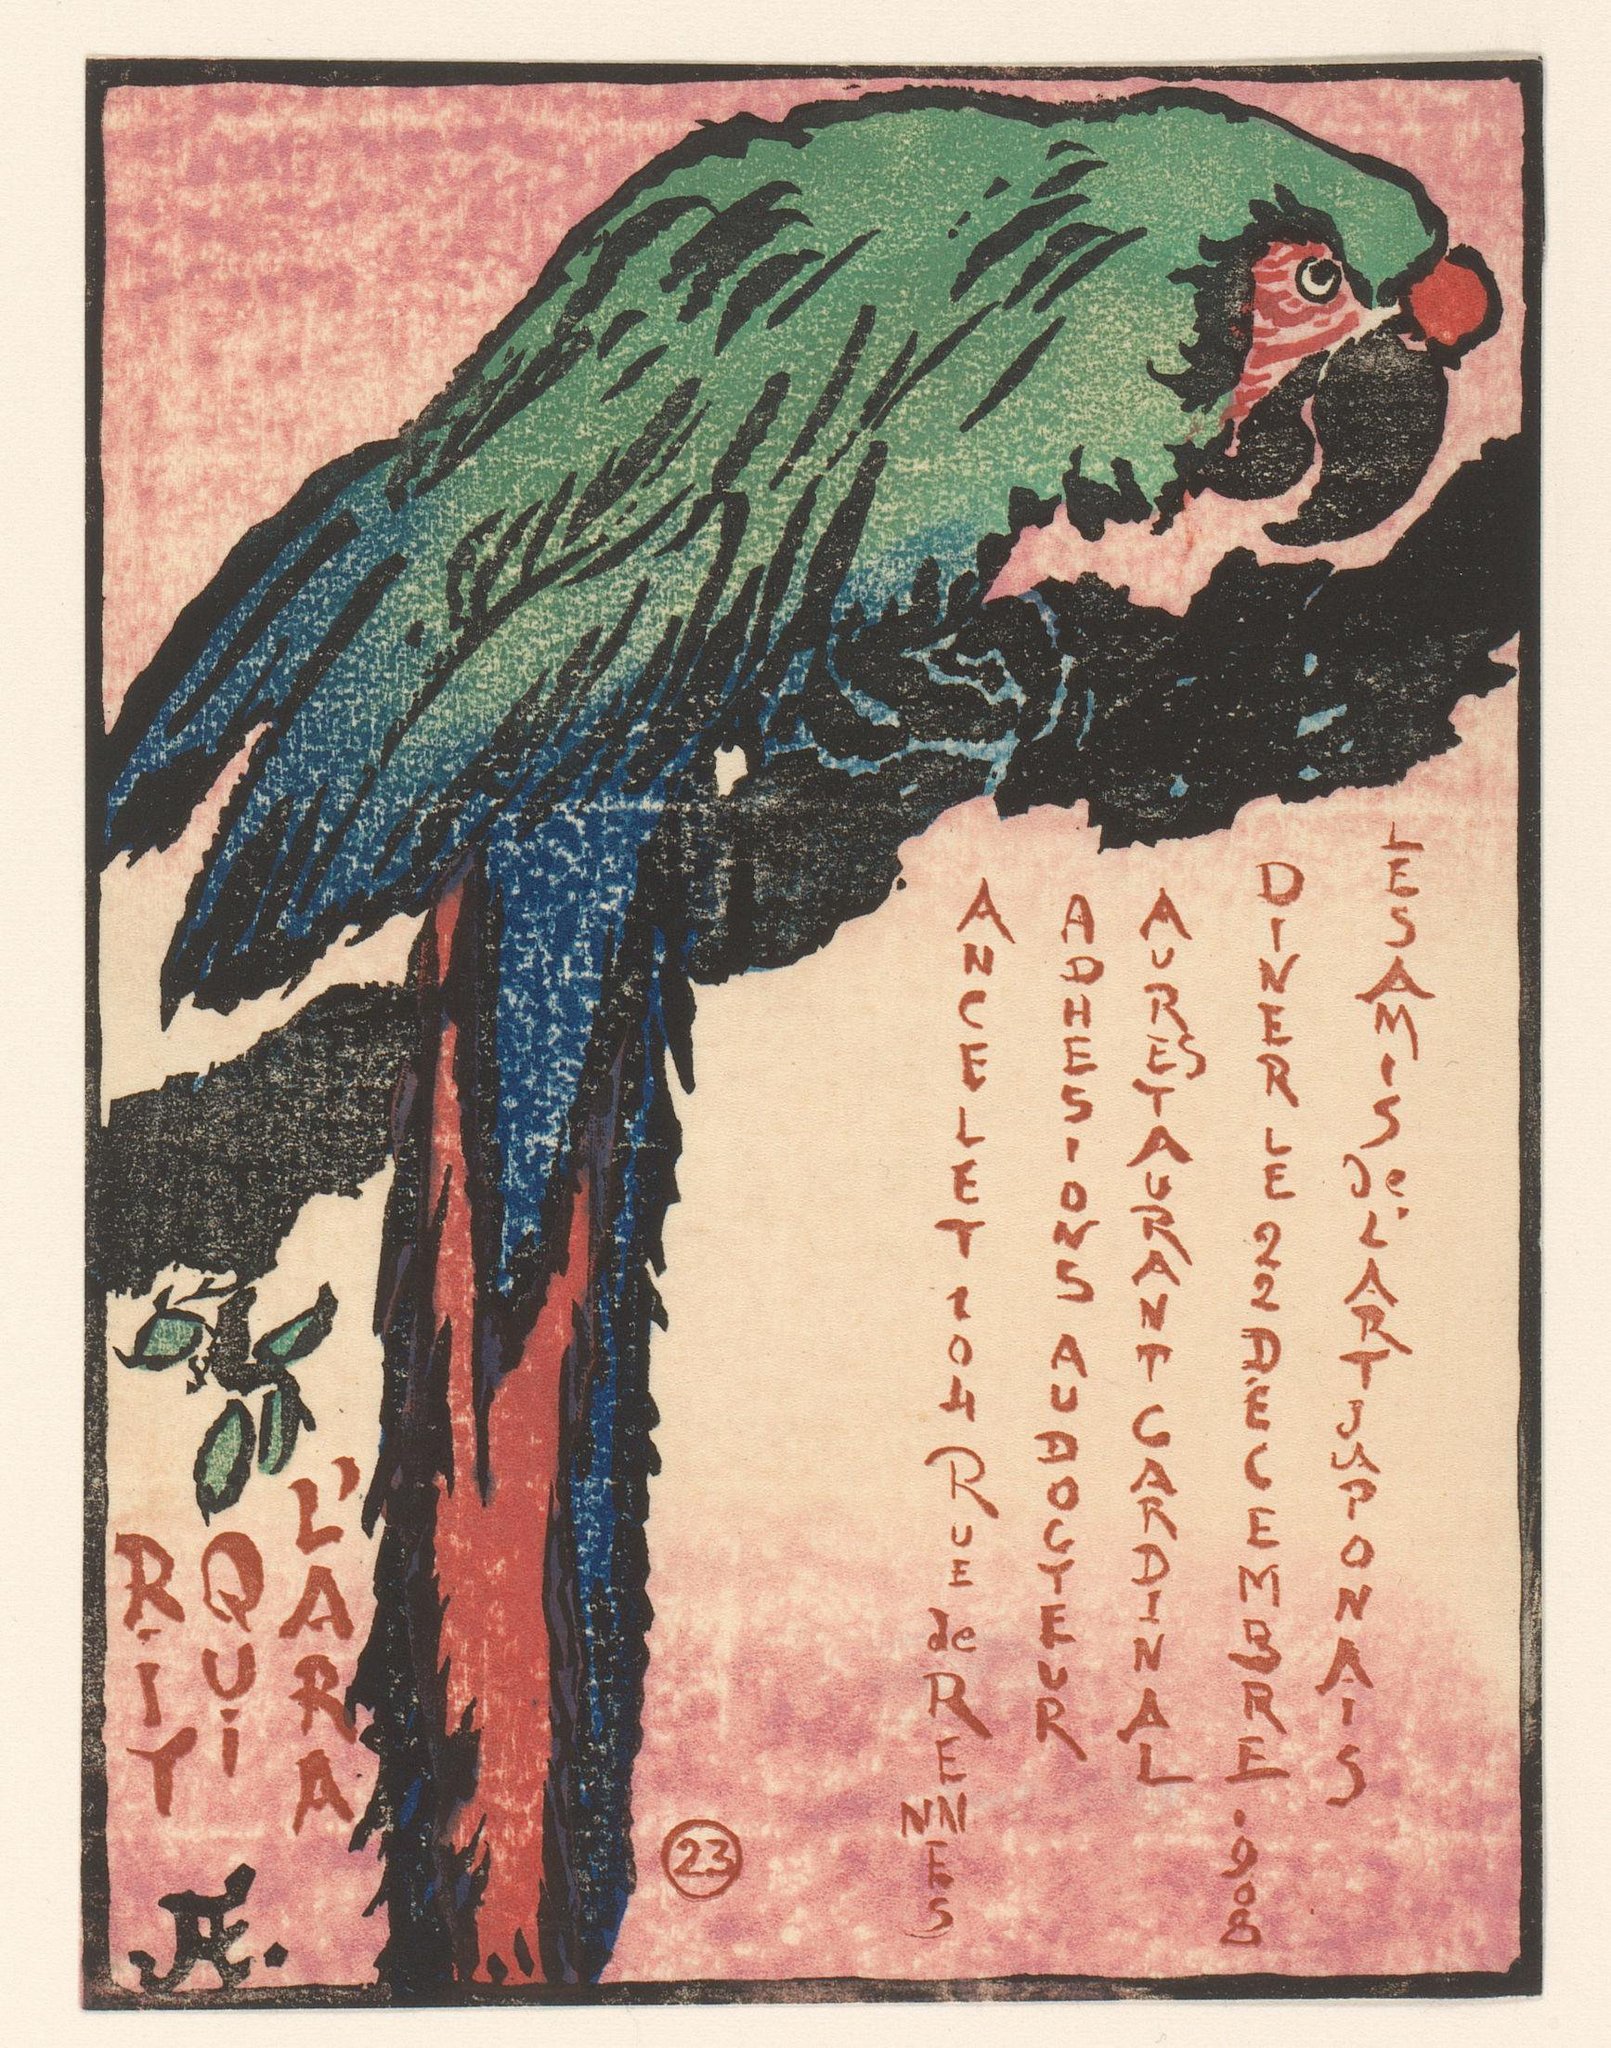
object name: print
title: Uitnodiging voor een diner van Les Amis de l'Art Japonais, 22 december 1908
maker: jean-francis auburtin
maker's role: draughtsman, painter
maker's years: 1866-1930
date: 1908-1912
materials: paper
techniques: woodcut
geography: france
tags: ornamental birds: parrot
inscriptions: collector's mark: Lugt 2228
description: Papegaai. Uitnodiging voor een diner van Les Amis de l'Art Japonais, 22 december 1908.